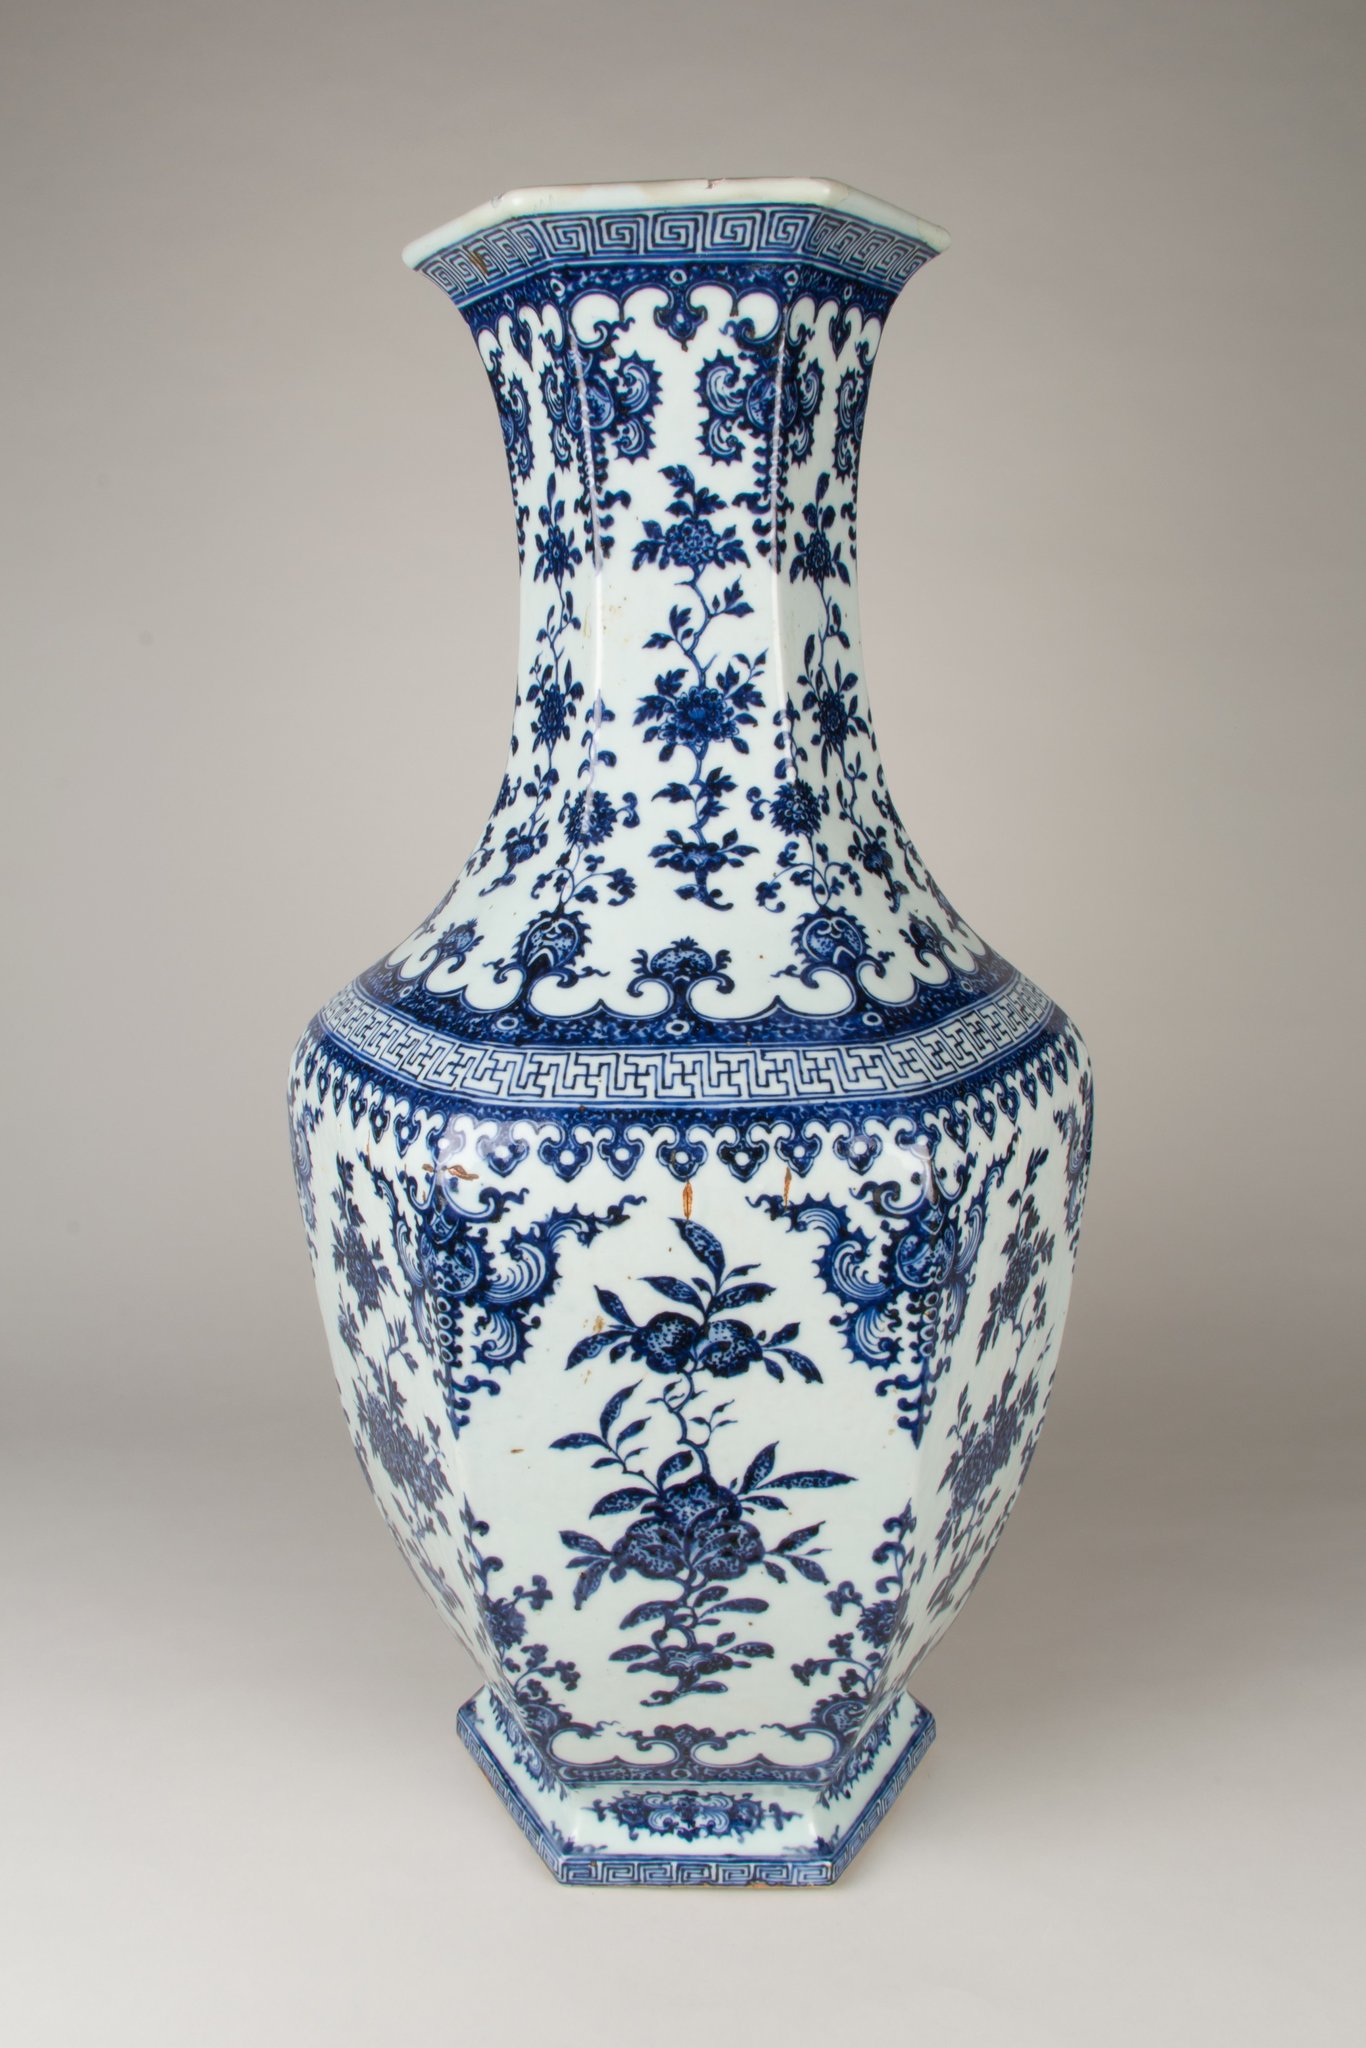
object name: vase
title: Hexagonal vase with Rococo-style flowers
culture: chinese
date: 1701-1800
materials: cobalt, porcelain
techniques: painting, underglaze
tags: flowers